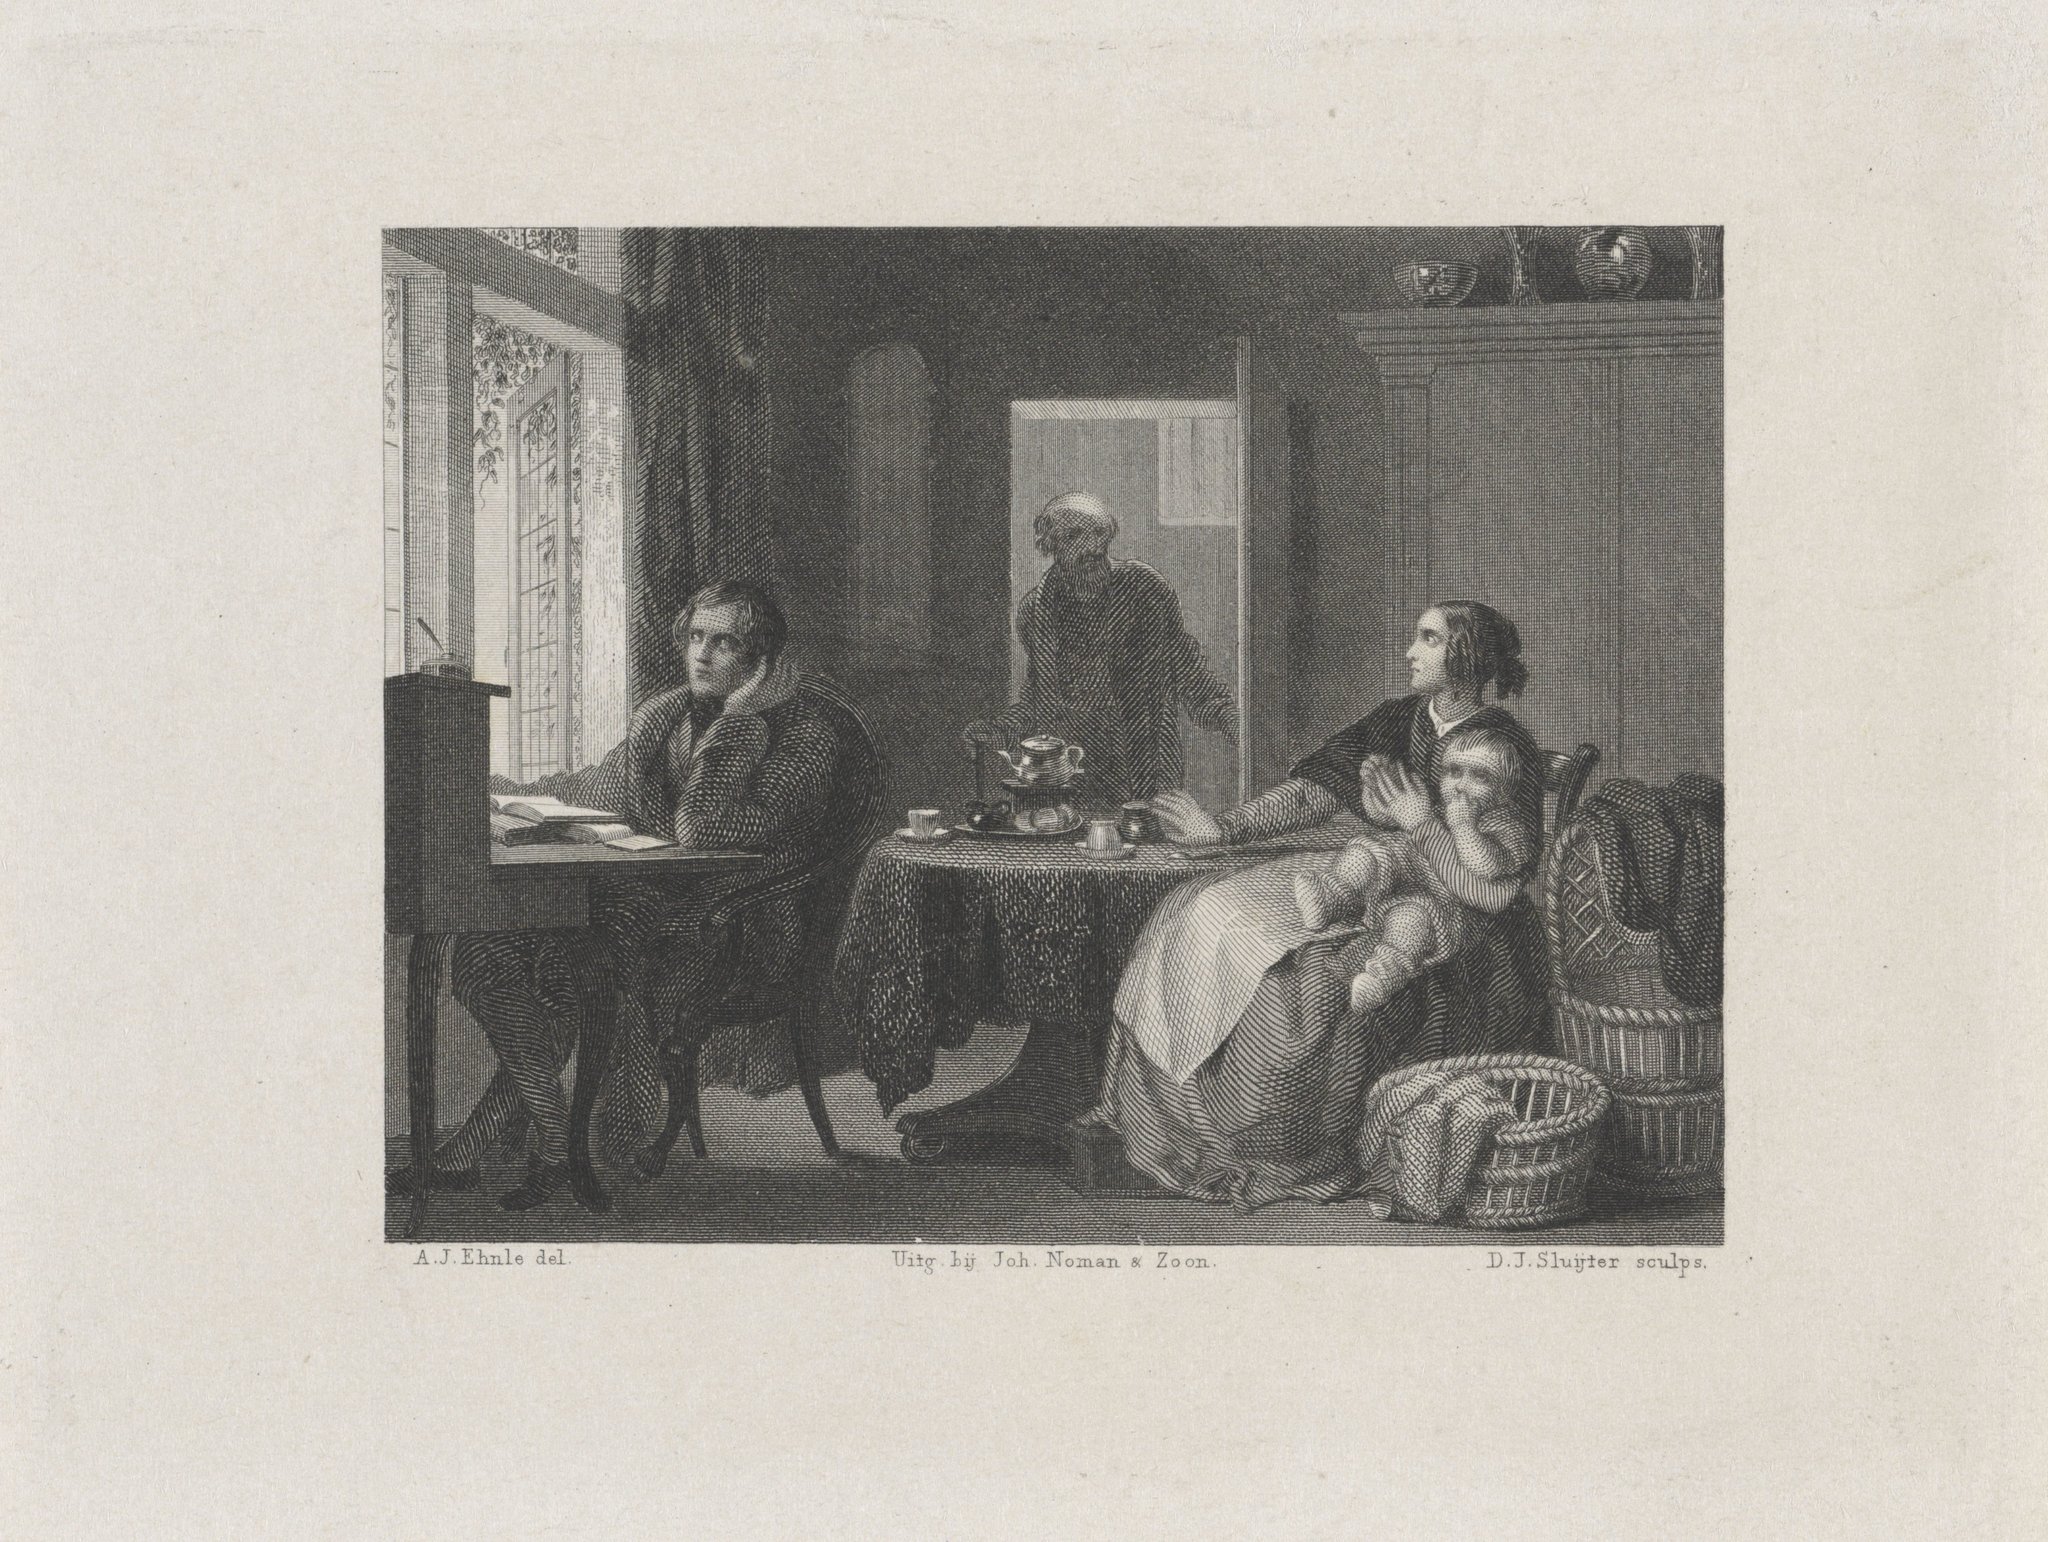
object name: print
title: Familie aan de theetafel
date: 1830-1851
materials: paper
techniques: engraving, etching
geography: amsterdam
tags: afternoon tea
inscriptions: collector's mark: Lugt 2228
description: Een man zit aan een secretaire voor een open raam. Achter hem zit een vrouw aan een tafel waarop thee geserveerd staat. Zij heeft een dreumes op schoot. Een oudere man met wandelstok komt de kamer binnen.